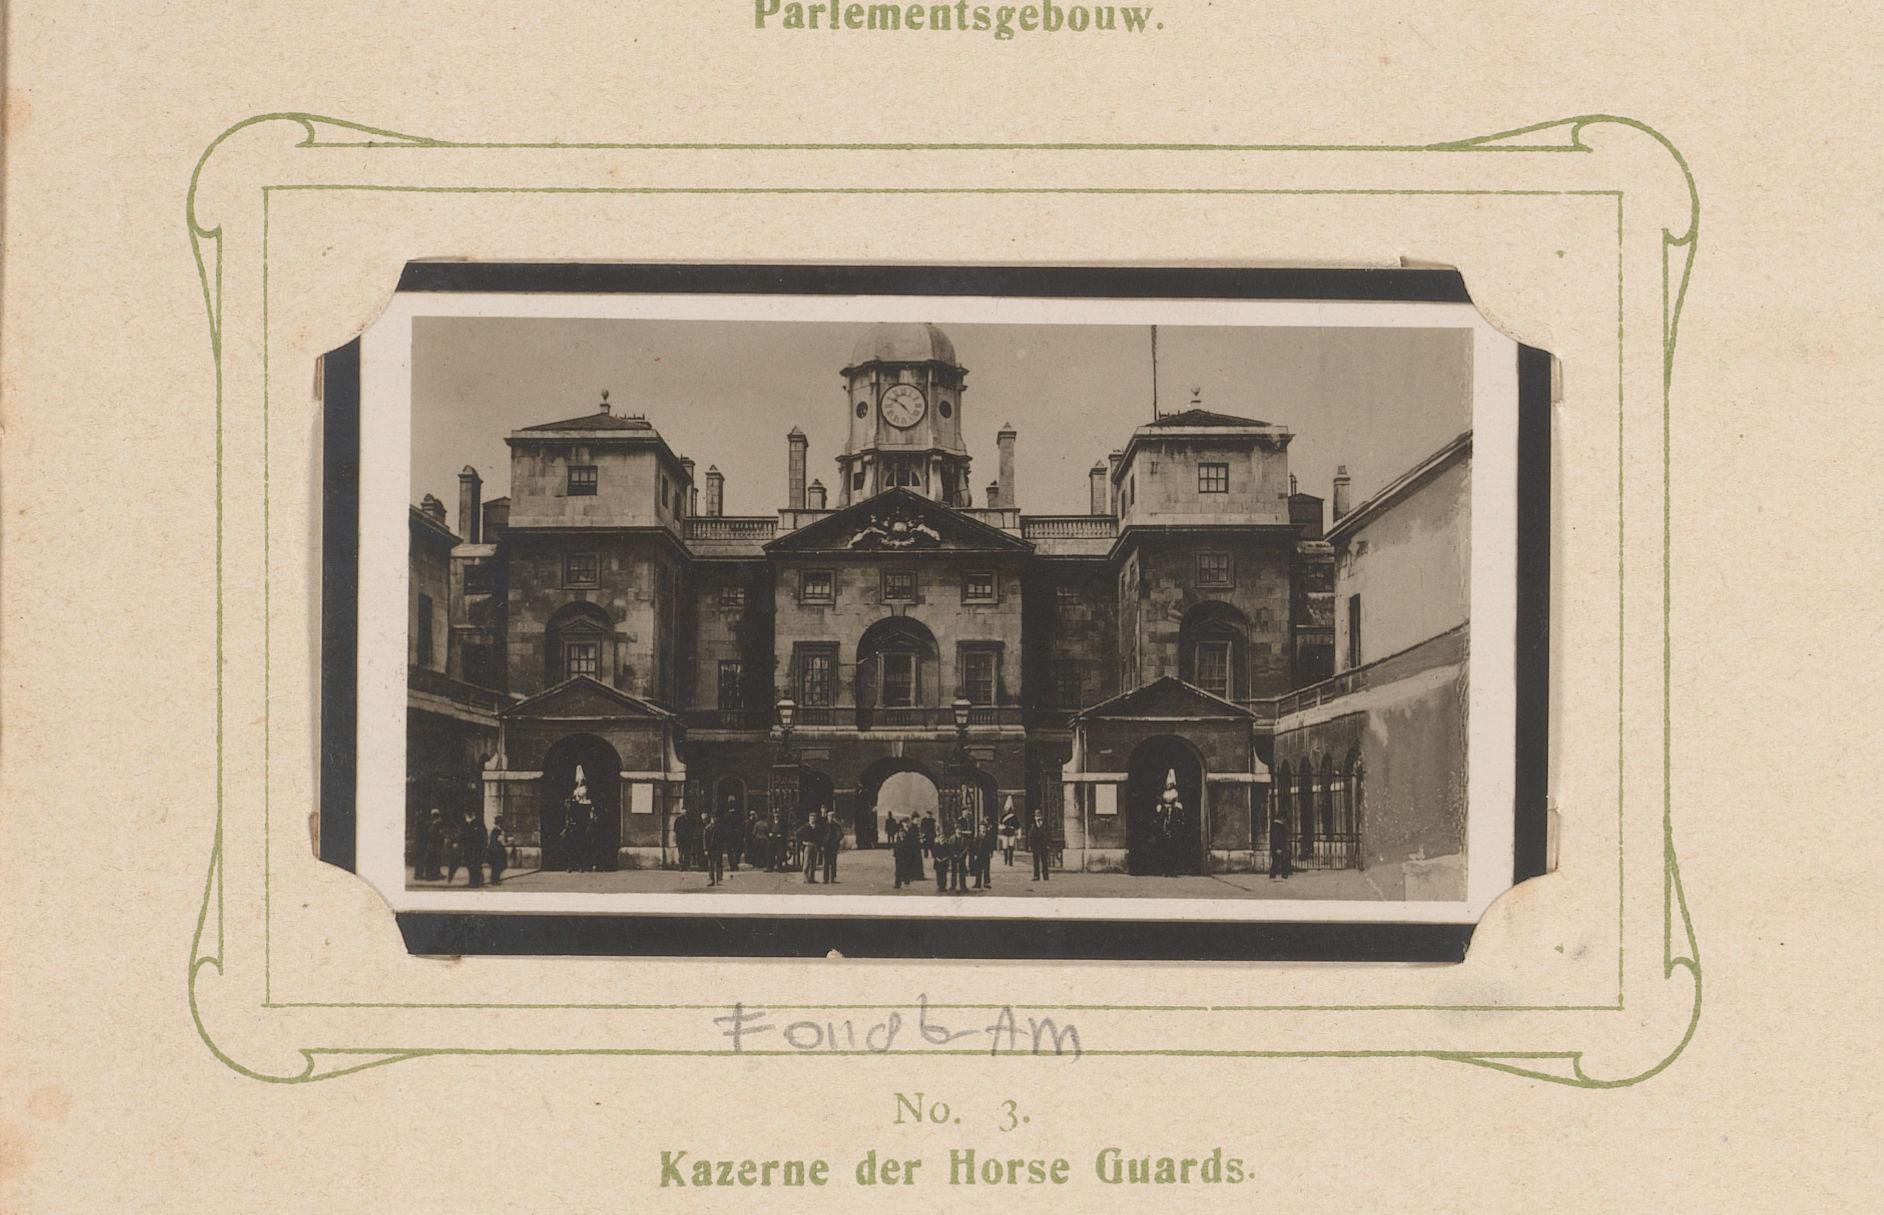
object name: photograph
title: Gezicht op het Horse Guards gebouw te Londen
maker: Anonymous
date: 1904-1905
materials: photographic support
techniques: gelatin silver print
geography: london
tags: façade (of house or building), street (+ city(-scape) with figures, staffage)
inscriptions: inscription: ‘No.3./ Kazerne der Horse Guards.’